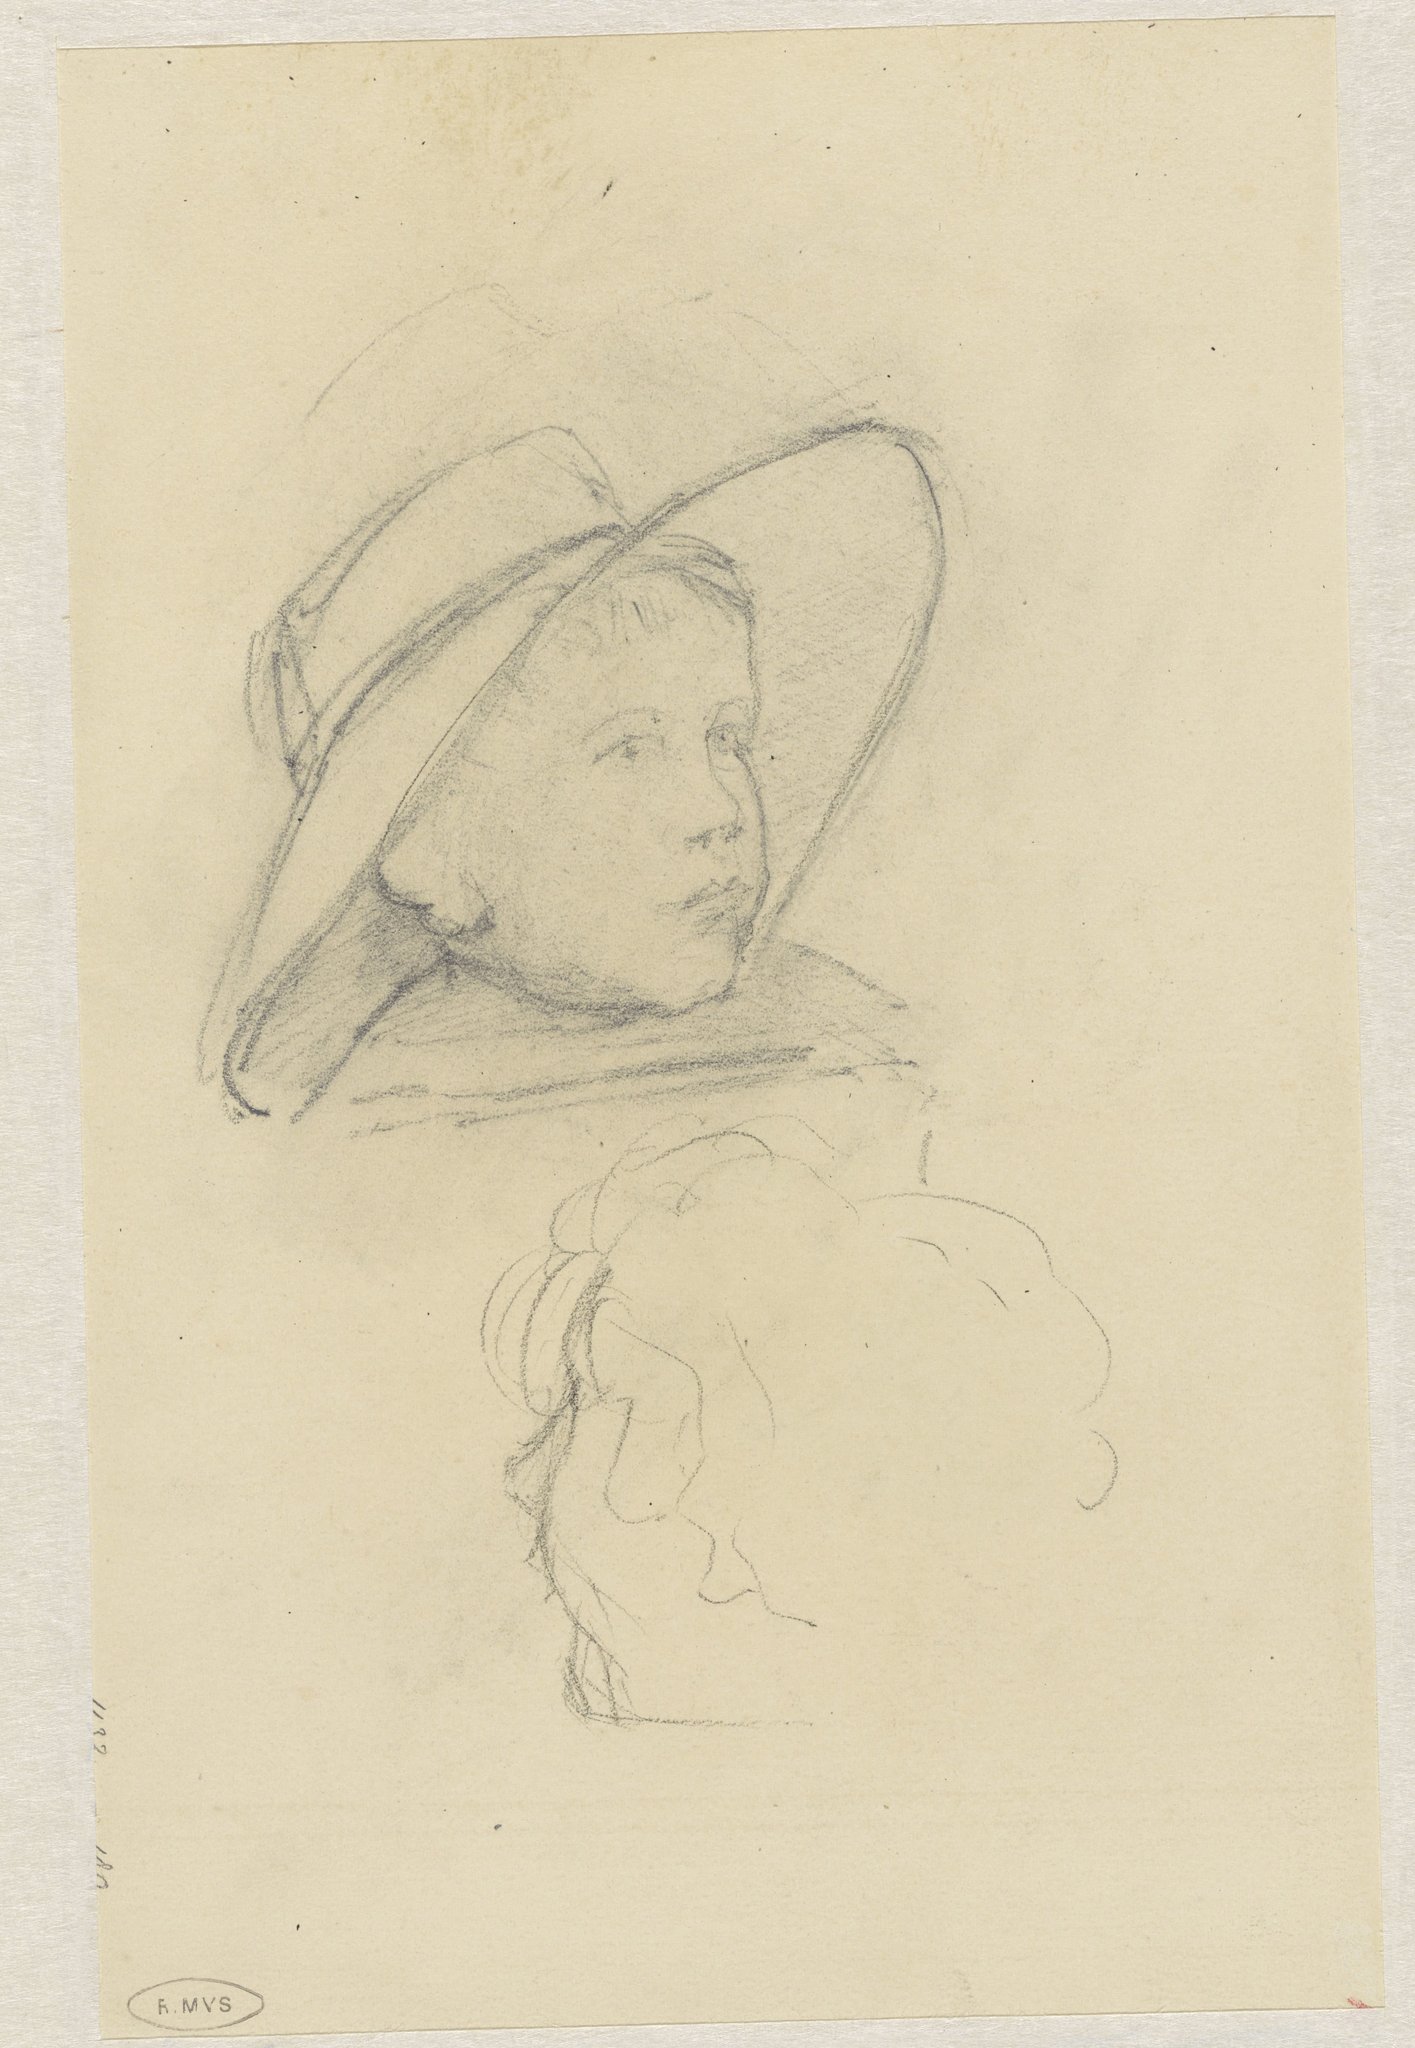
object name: drawing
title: Hoofd van een jongetje met een hoed en schets van een hoofd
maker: jozef israëls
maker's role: draughtsman, painter, print maker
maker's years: 1824-1911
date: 1834-1911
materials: chalk, paper